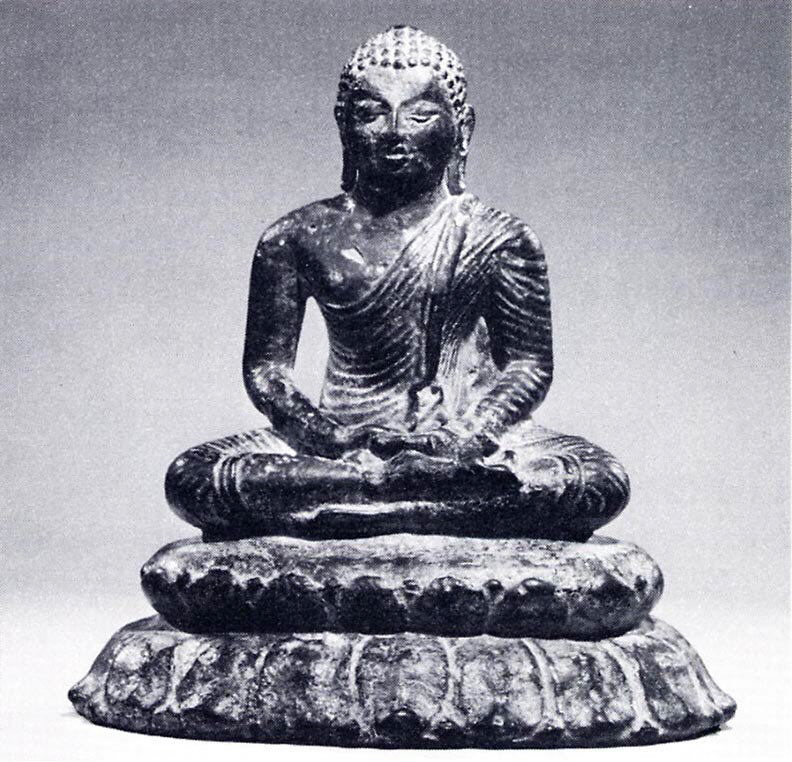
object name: figure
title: Buddha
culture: sri lankan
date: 501-600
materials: bronze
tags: buddhism,buddha